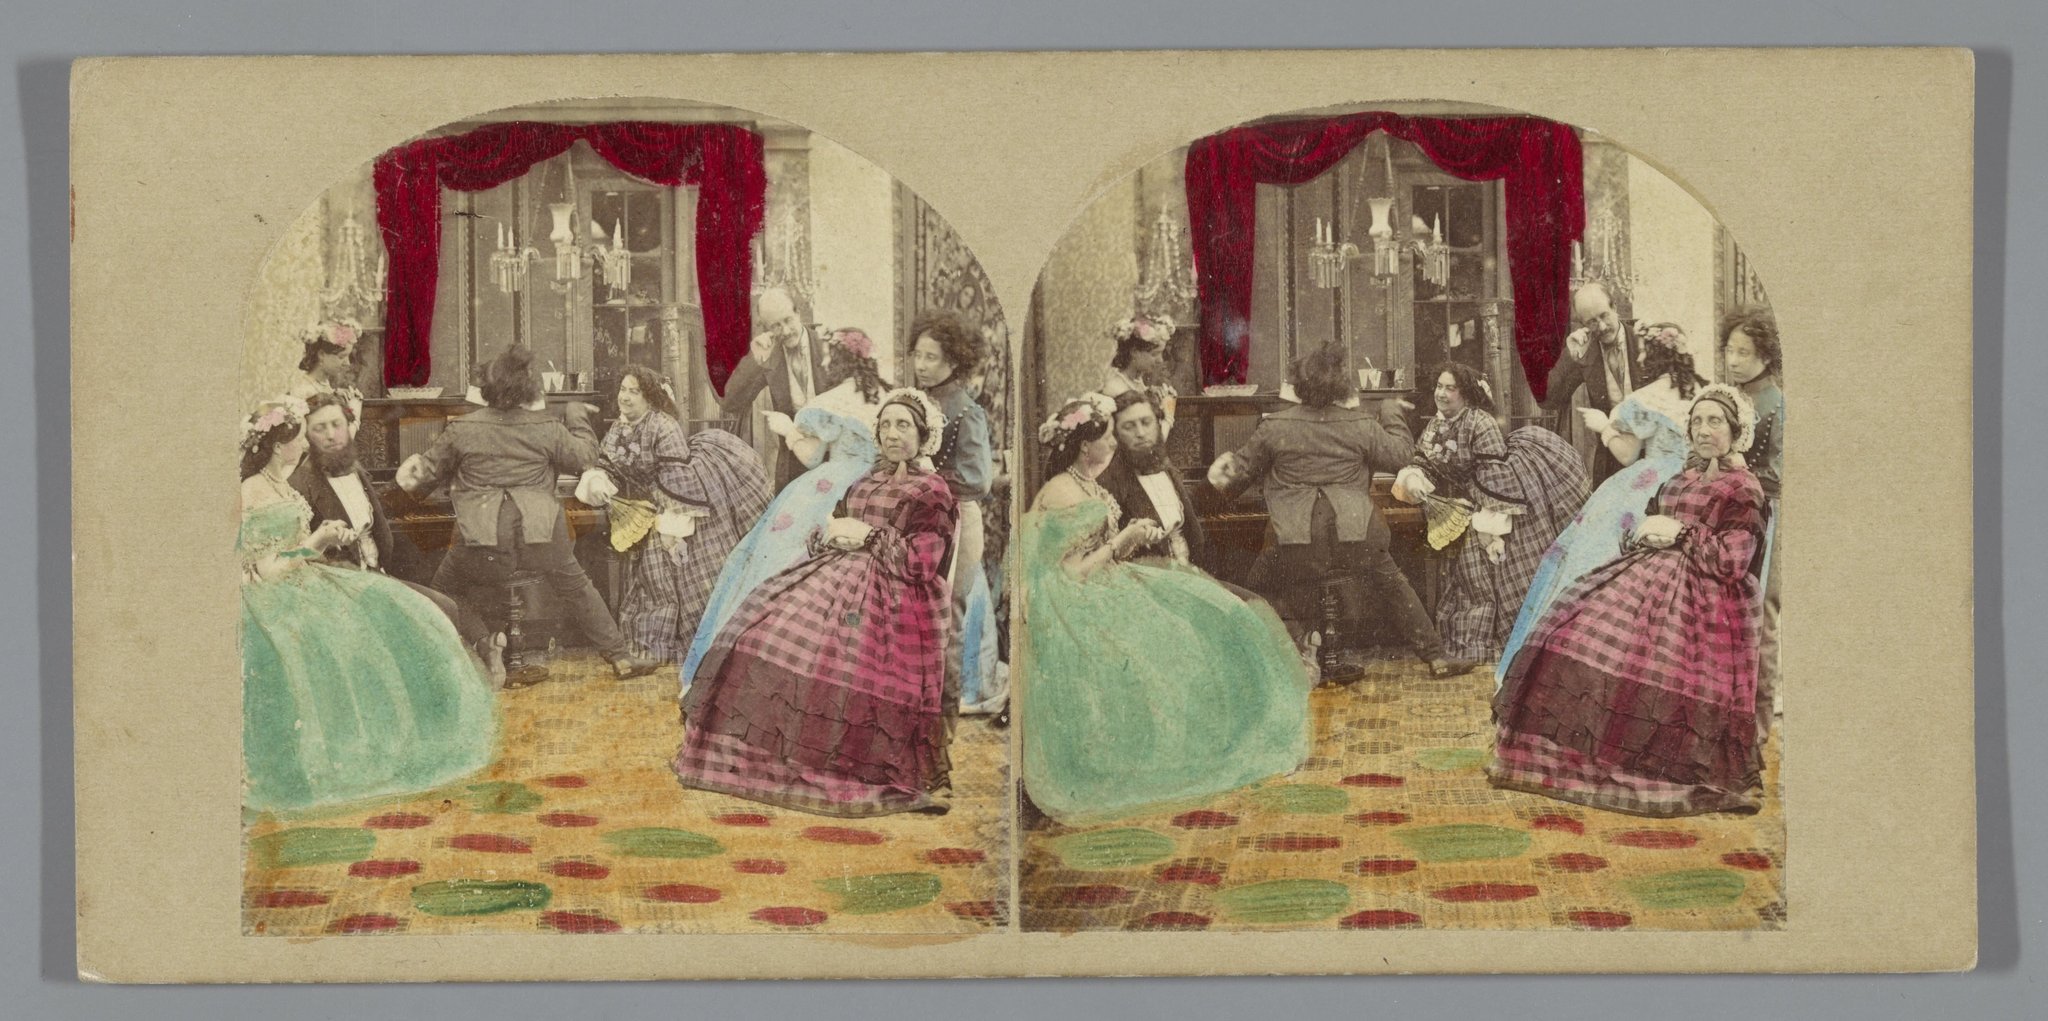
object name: stereograph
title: Evening Parties. Mr. Bottomly treats the Company to his New Fantasia and his Great Finale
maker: Anonymous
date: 1852-1863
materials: cardboard, paper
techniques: albumen print, hand coloring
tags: drawing-room, 'salon', making music; musician with instrument, recreation, amusement